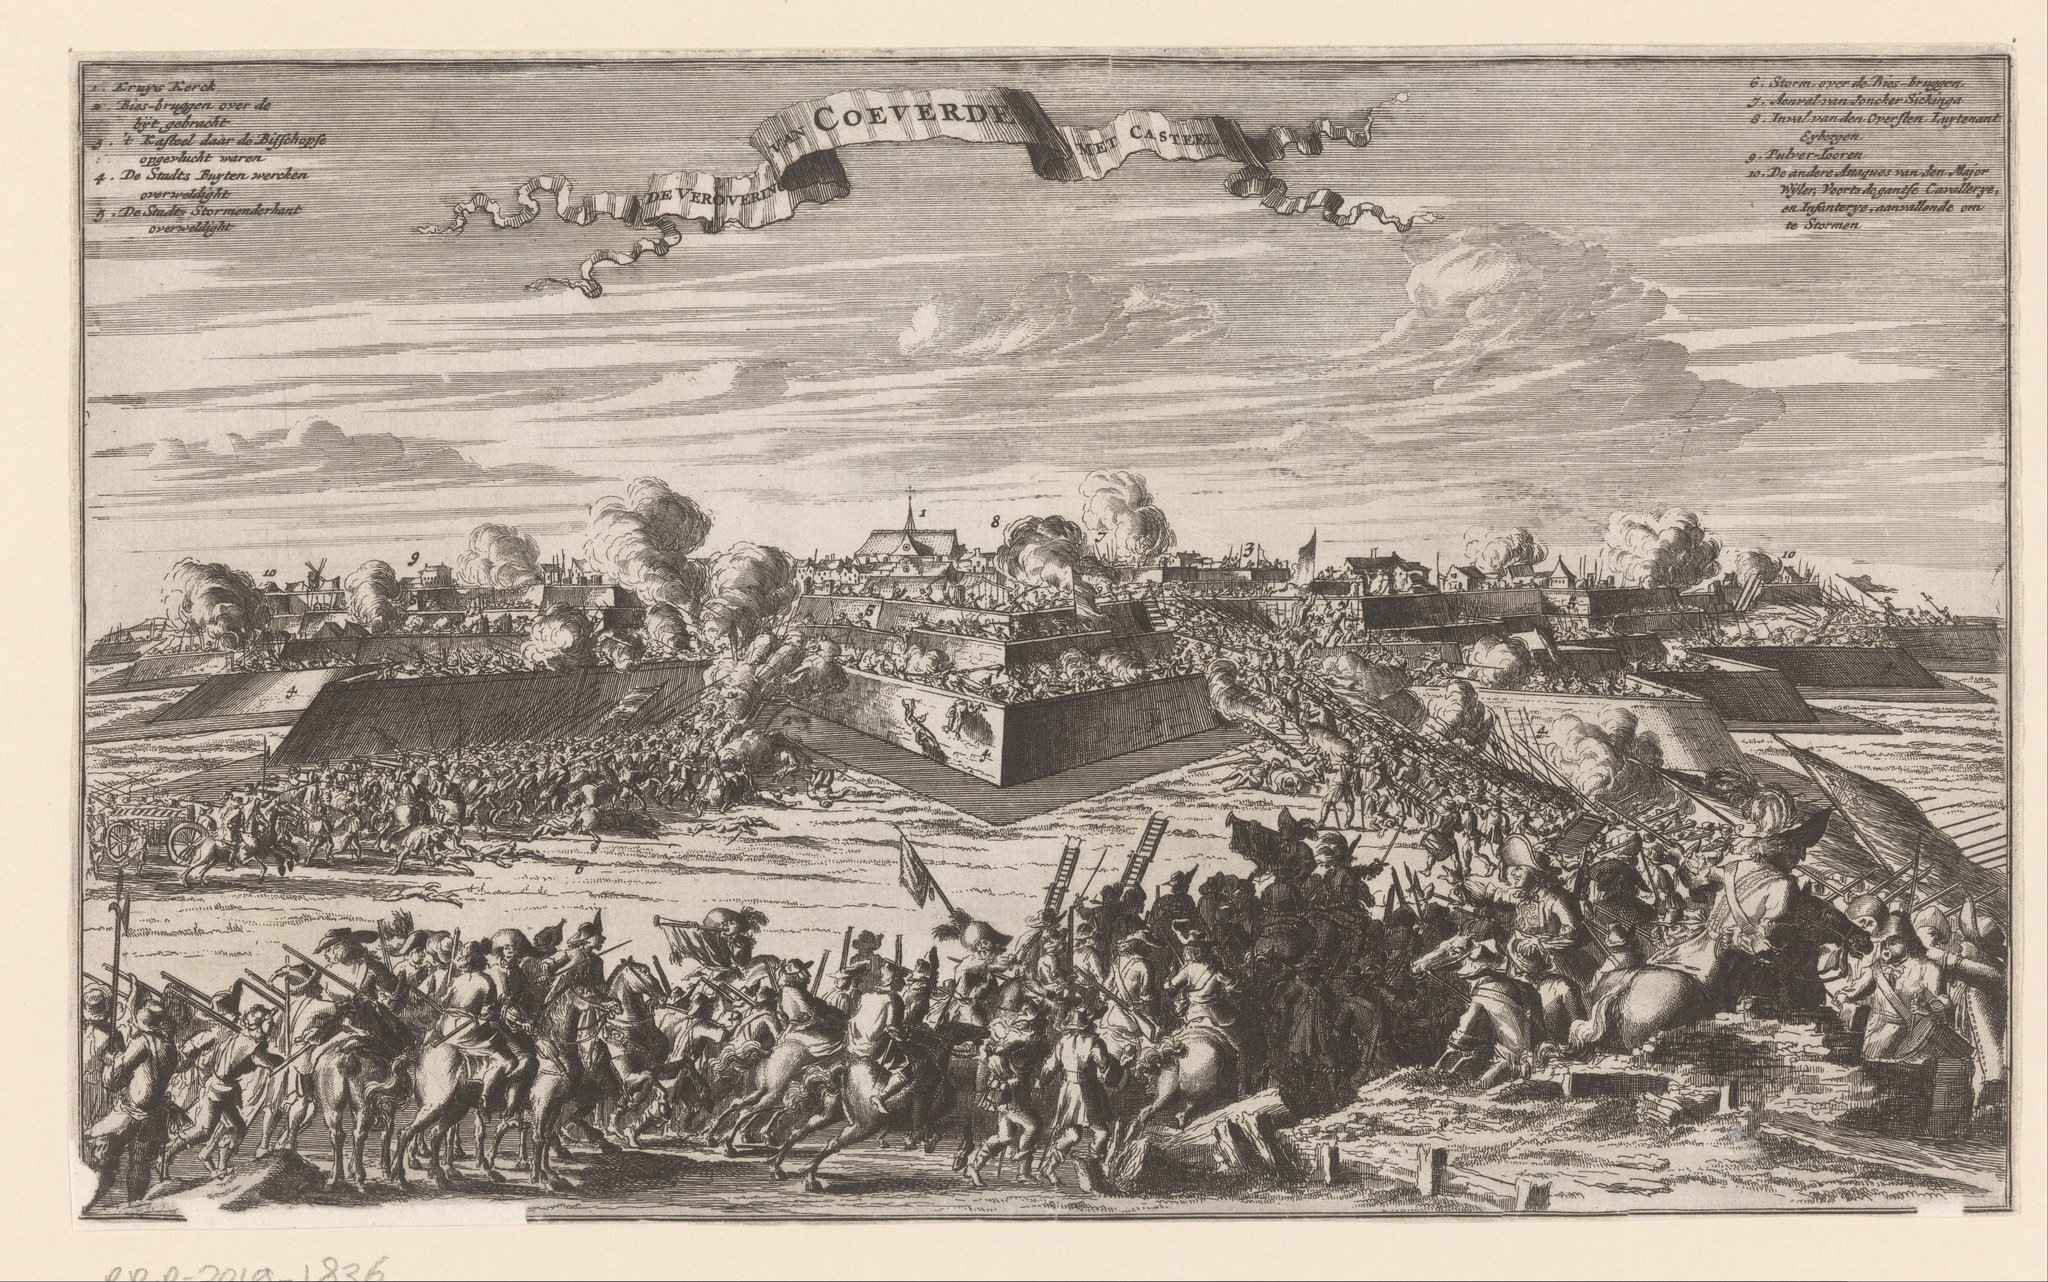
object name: print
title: Verovering van Coevorden, 1672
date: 1677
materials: paper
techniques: etching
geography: netherlands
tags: capture of city (after the siege), fortified city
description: Prent uit: Valckenier, Petrus. Das Verwirrte Europa (...). Amsterdam: Jacob van Meurs et al., 1677, dl. 1, p. 448. Spiegelbeeldige kopie naar de prent uit 1673 toegeschreven aan Romeyn de Hooghe (FMH 2445a). Nieuw is de legenda in twee delen in de bovenhoeken van de voorstelling.